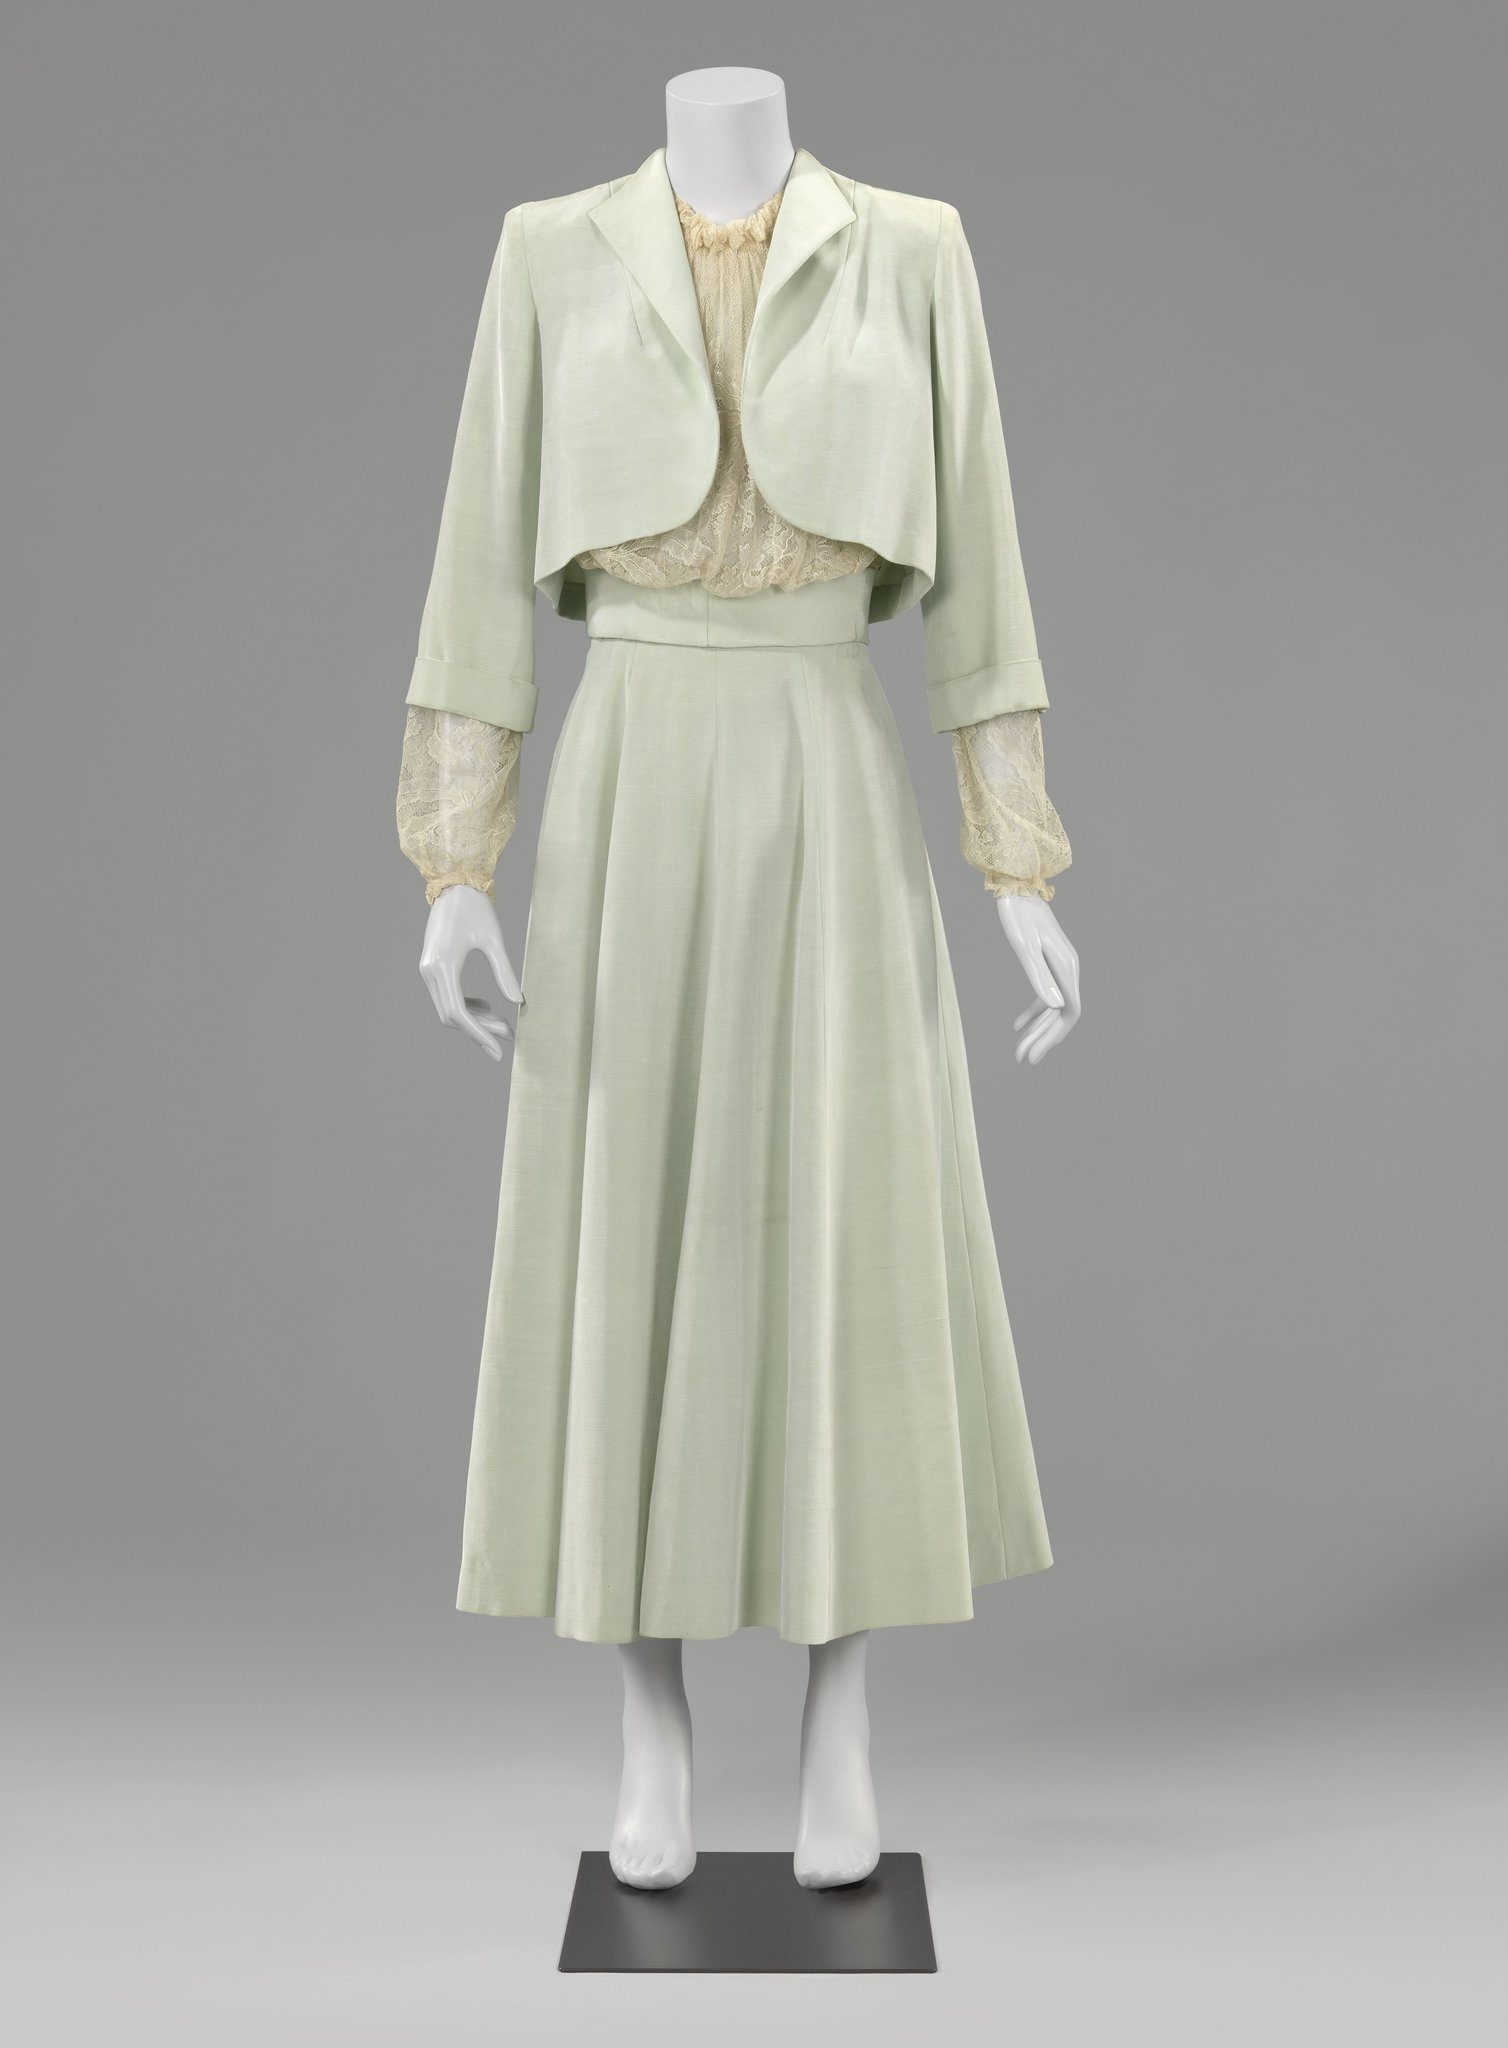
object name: wedding clothes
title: Klokkende rok met zeven banen, brede tailleband en achtersluiting met rits van geribd moiré-zijde.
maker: mevrouw stapelveld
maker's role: linnennaaister, naaister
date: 1948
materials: textile, silk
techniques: moire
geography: netherlands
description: Klokkende rok van mantelpak met een brede tailleband. Rok van geribde moiré satijn. Ongevoerd.